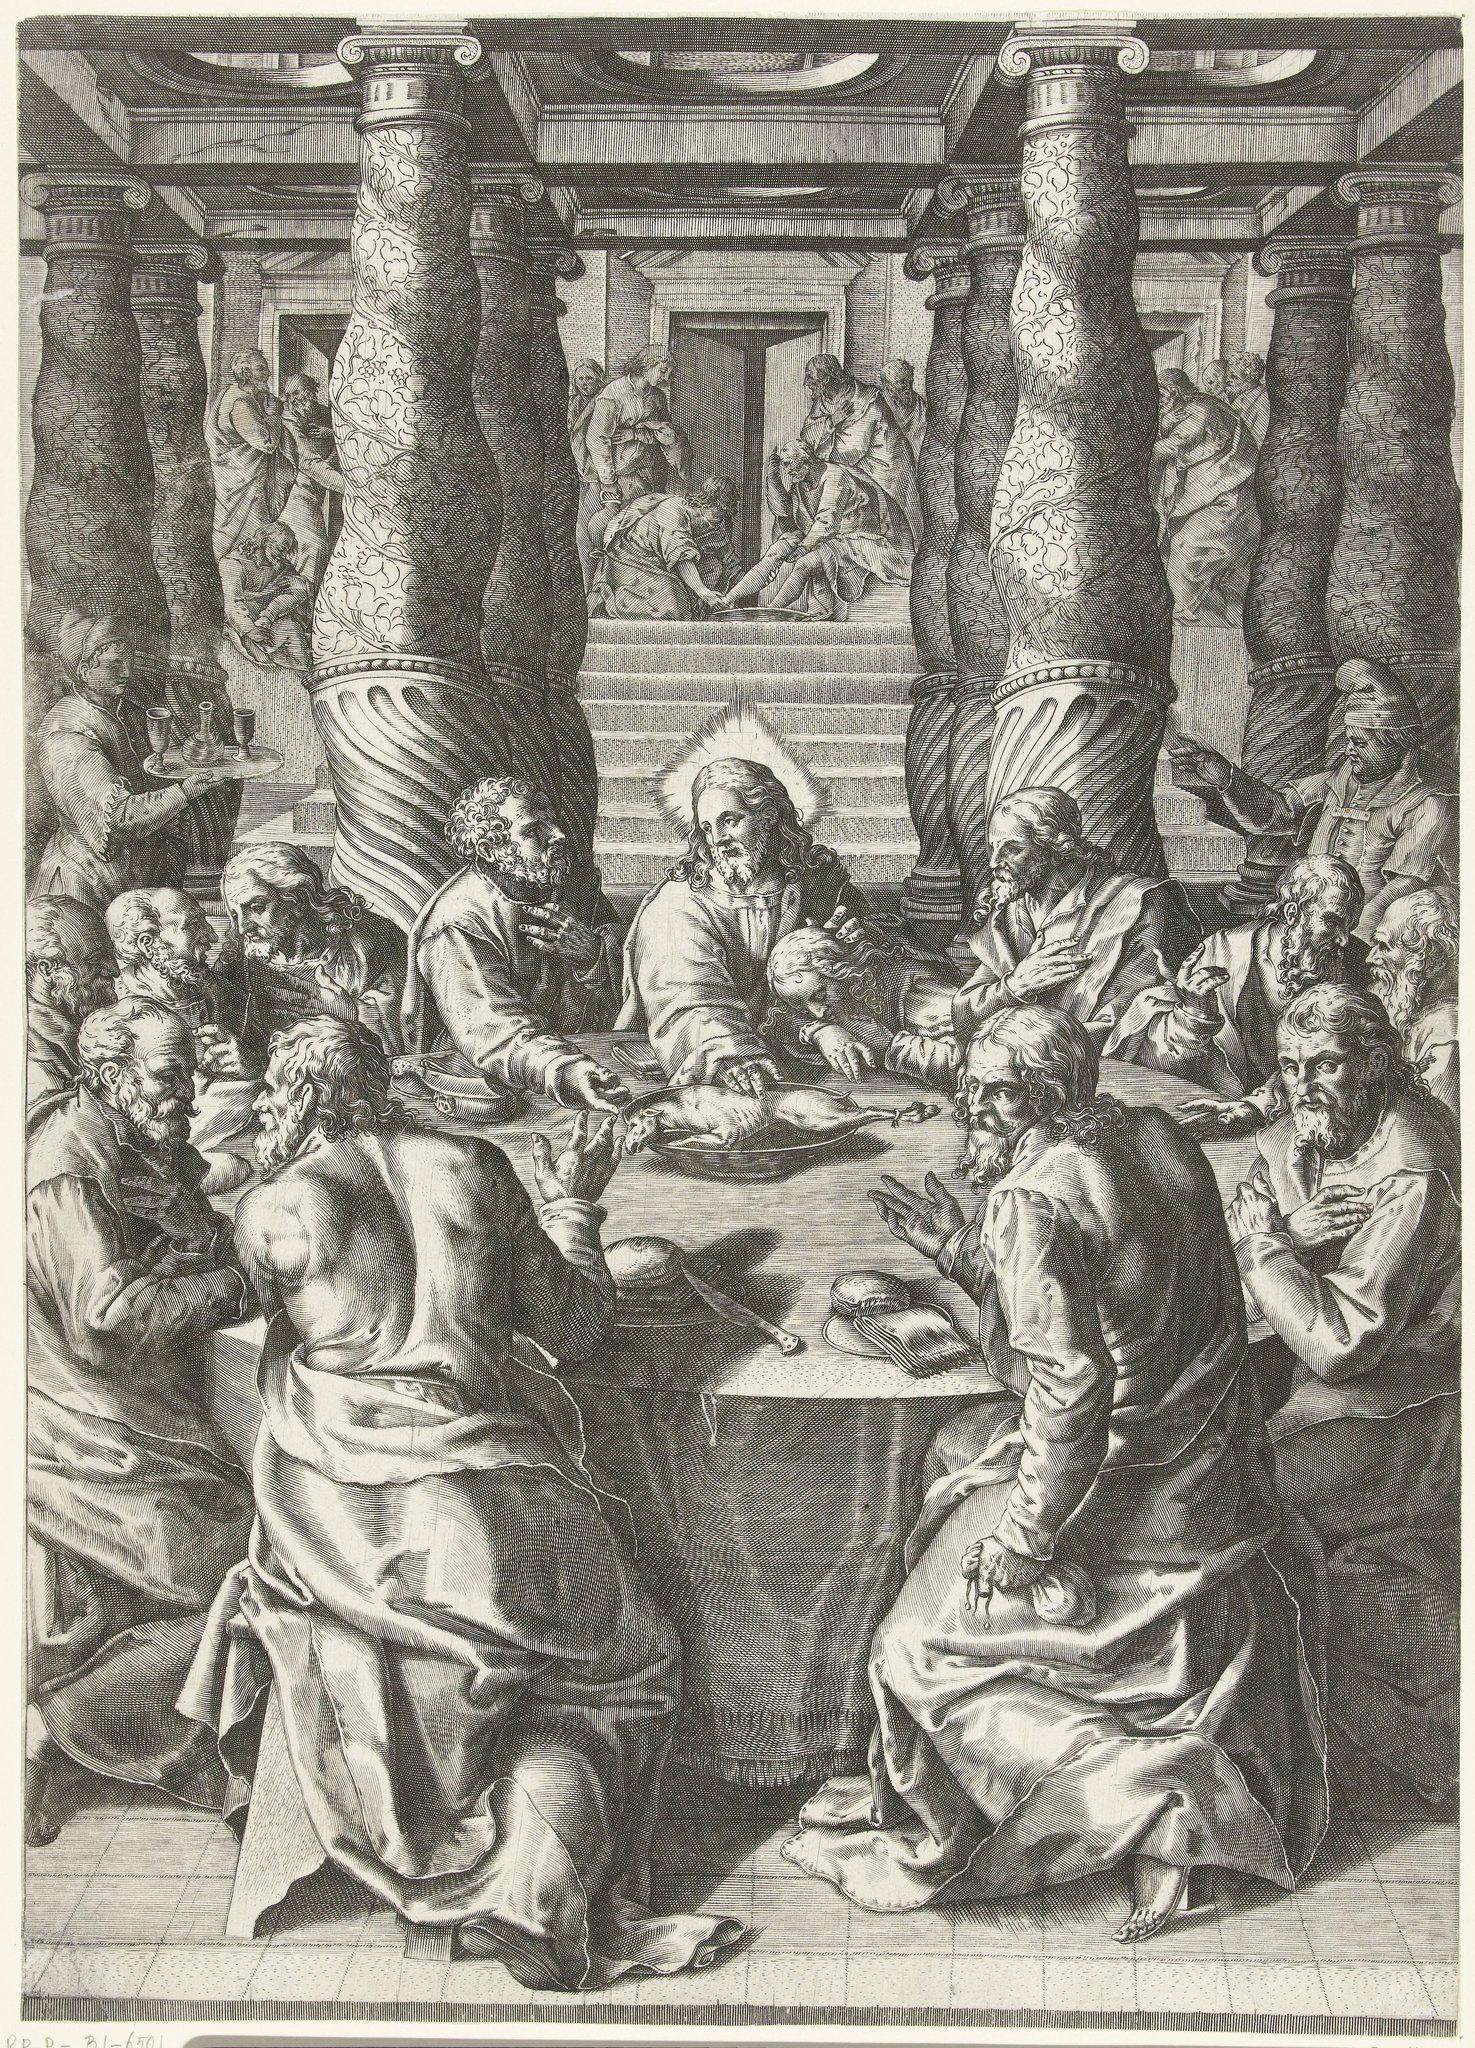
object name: print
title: Laatste avondmaal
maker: Anonymous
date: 1578-1628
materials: paper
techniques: engraving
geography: rome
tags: christ washes the feet of the apostles (john 13:1-20), last supper (in general) (matthew 26:21-35; mark 14:18-31; luke 22:3, 22:15-23; john 13:21-38)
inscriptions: collector's mark: Lugt 2228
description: In een ruimte met gedraaide zuilen zit Christus met zijn apostelen aan een ronde tafel aan het laatste avondmaal. Op tafel een schaal met een lam. Johannes zit rechts naast Christus, zijn hoofd op de handen. Rechtsvoor Judas met een beurs in zijn hand. Op de achtergrond tussen de zuilenrij door is de voetwassing te zien.